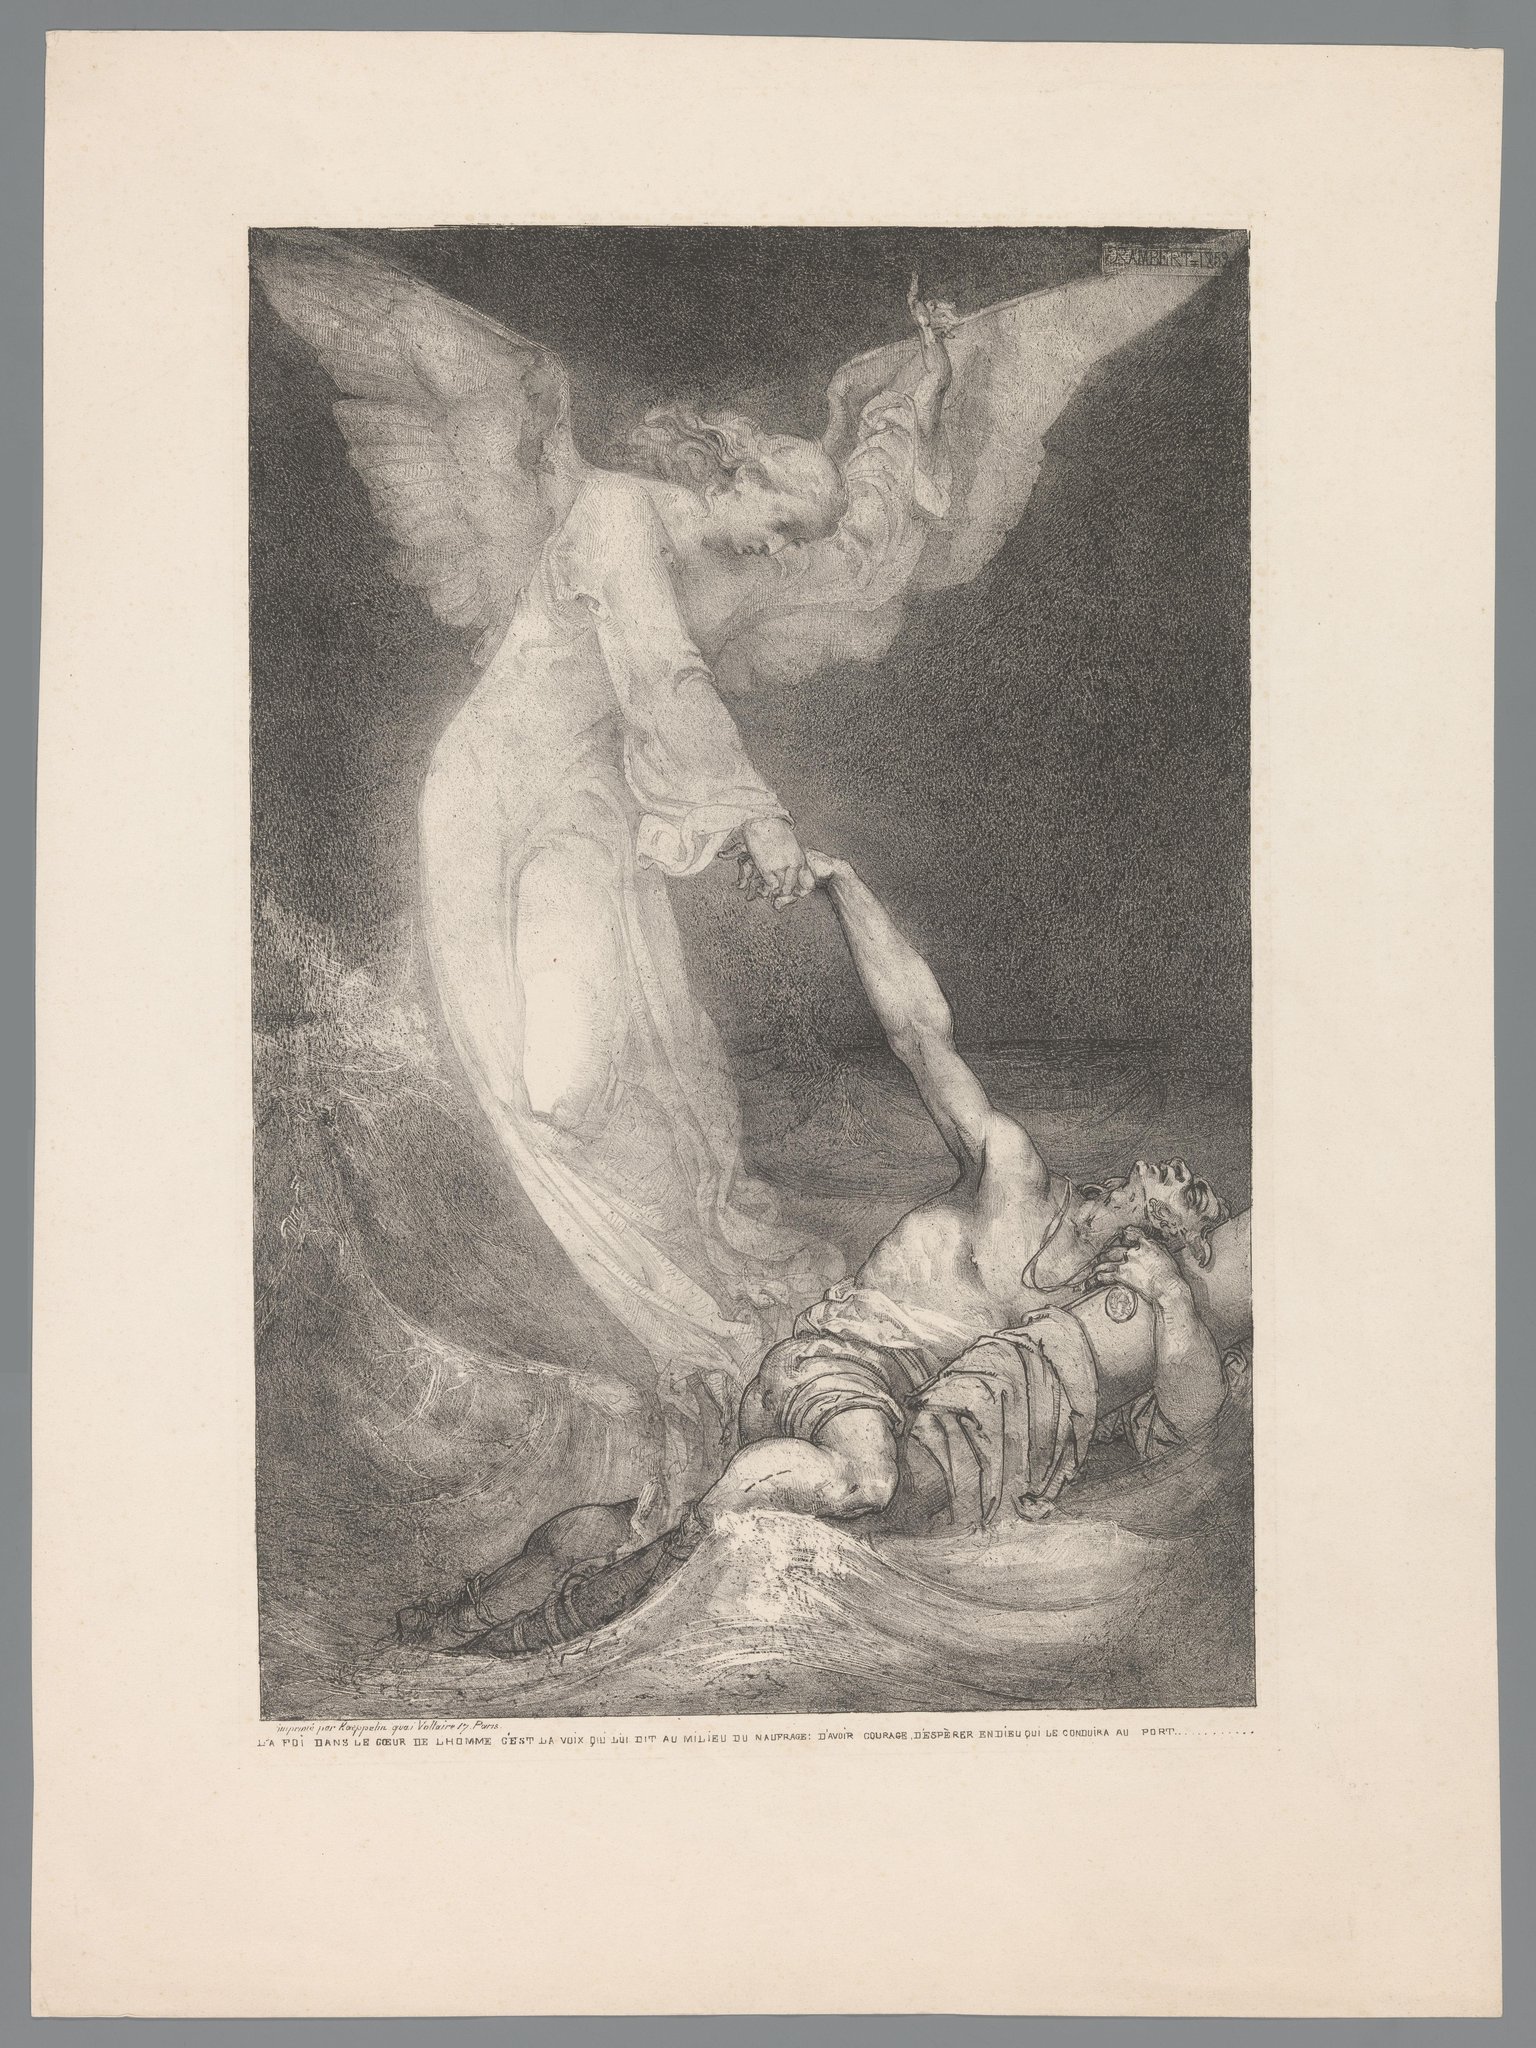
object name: print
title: Engel reikt man in verdrinkingsnood de hand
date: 1859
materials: paper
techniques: lithograph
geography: paris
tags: drowning, shipwrecked person, angels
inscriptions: collector's mark: Lugt 2228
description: Onderschrift: La foi dans le coeur de l'homme (...).